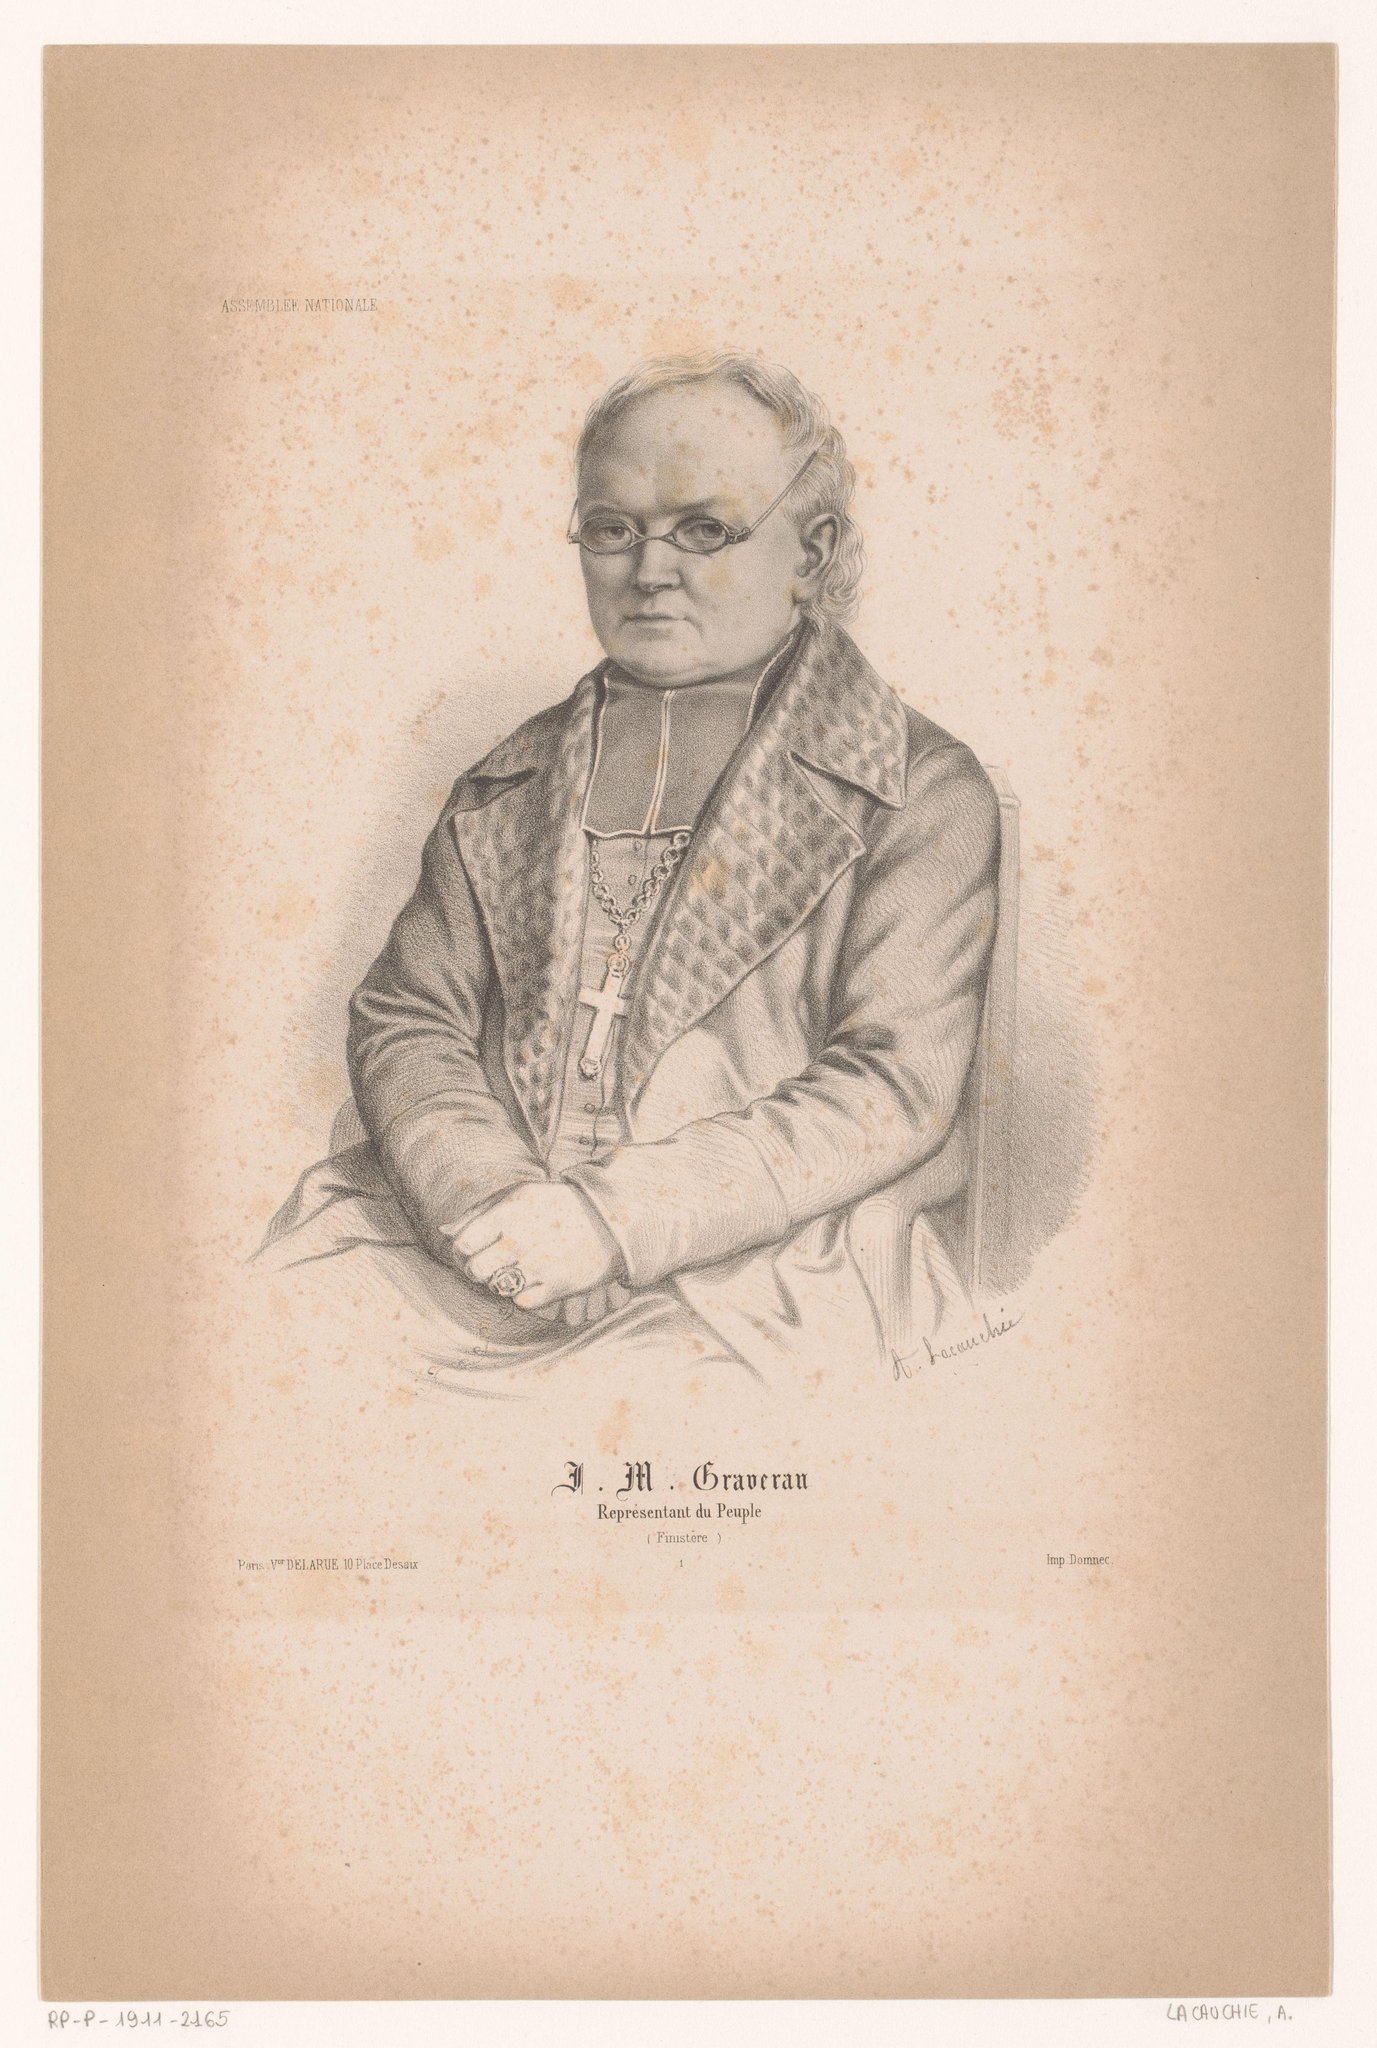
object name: print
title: J.M. Graveran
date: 1848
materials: paper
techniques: lithograph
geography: paris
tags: politician, historical persons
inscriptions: collector's mark: Lugt 2228a